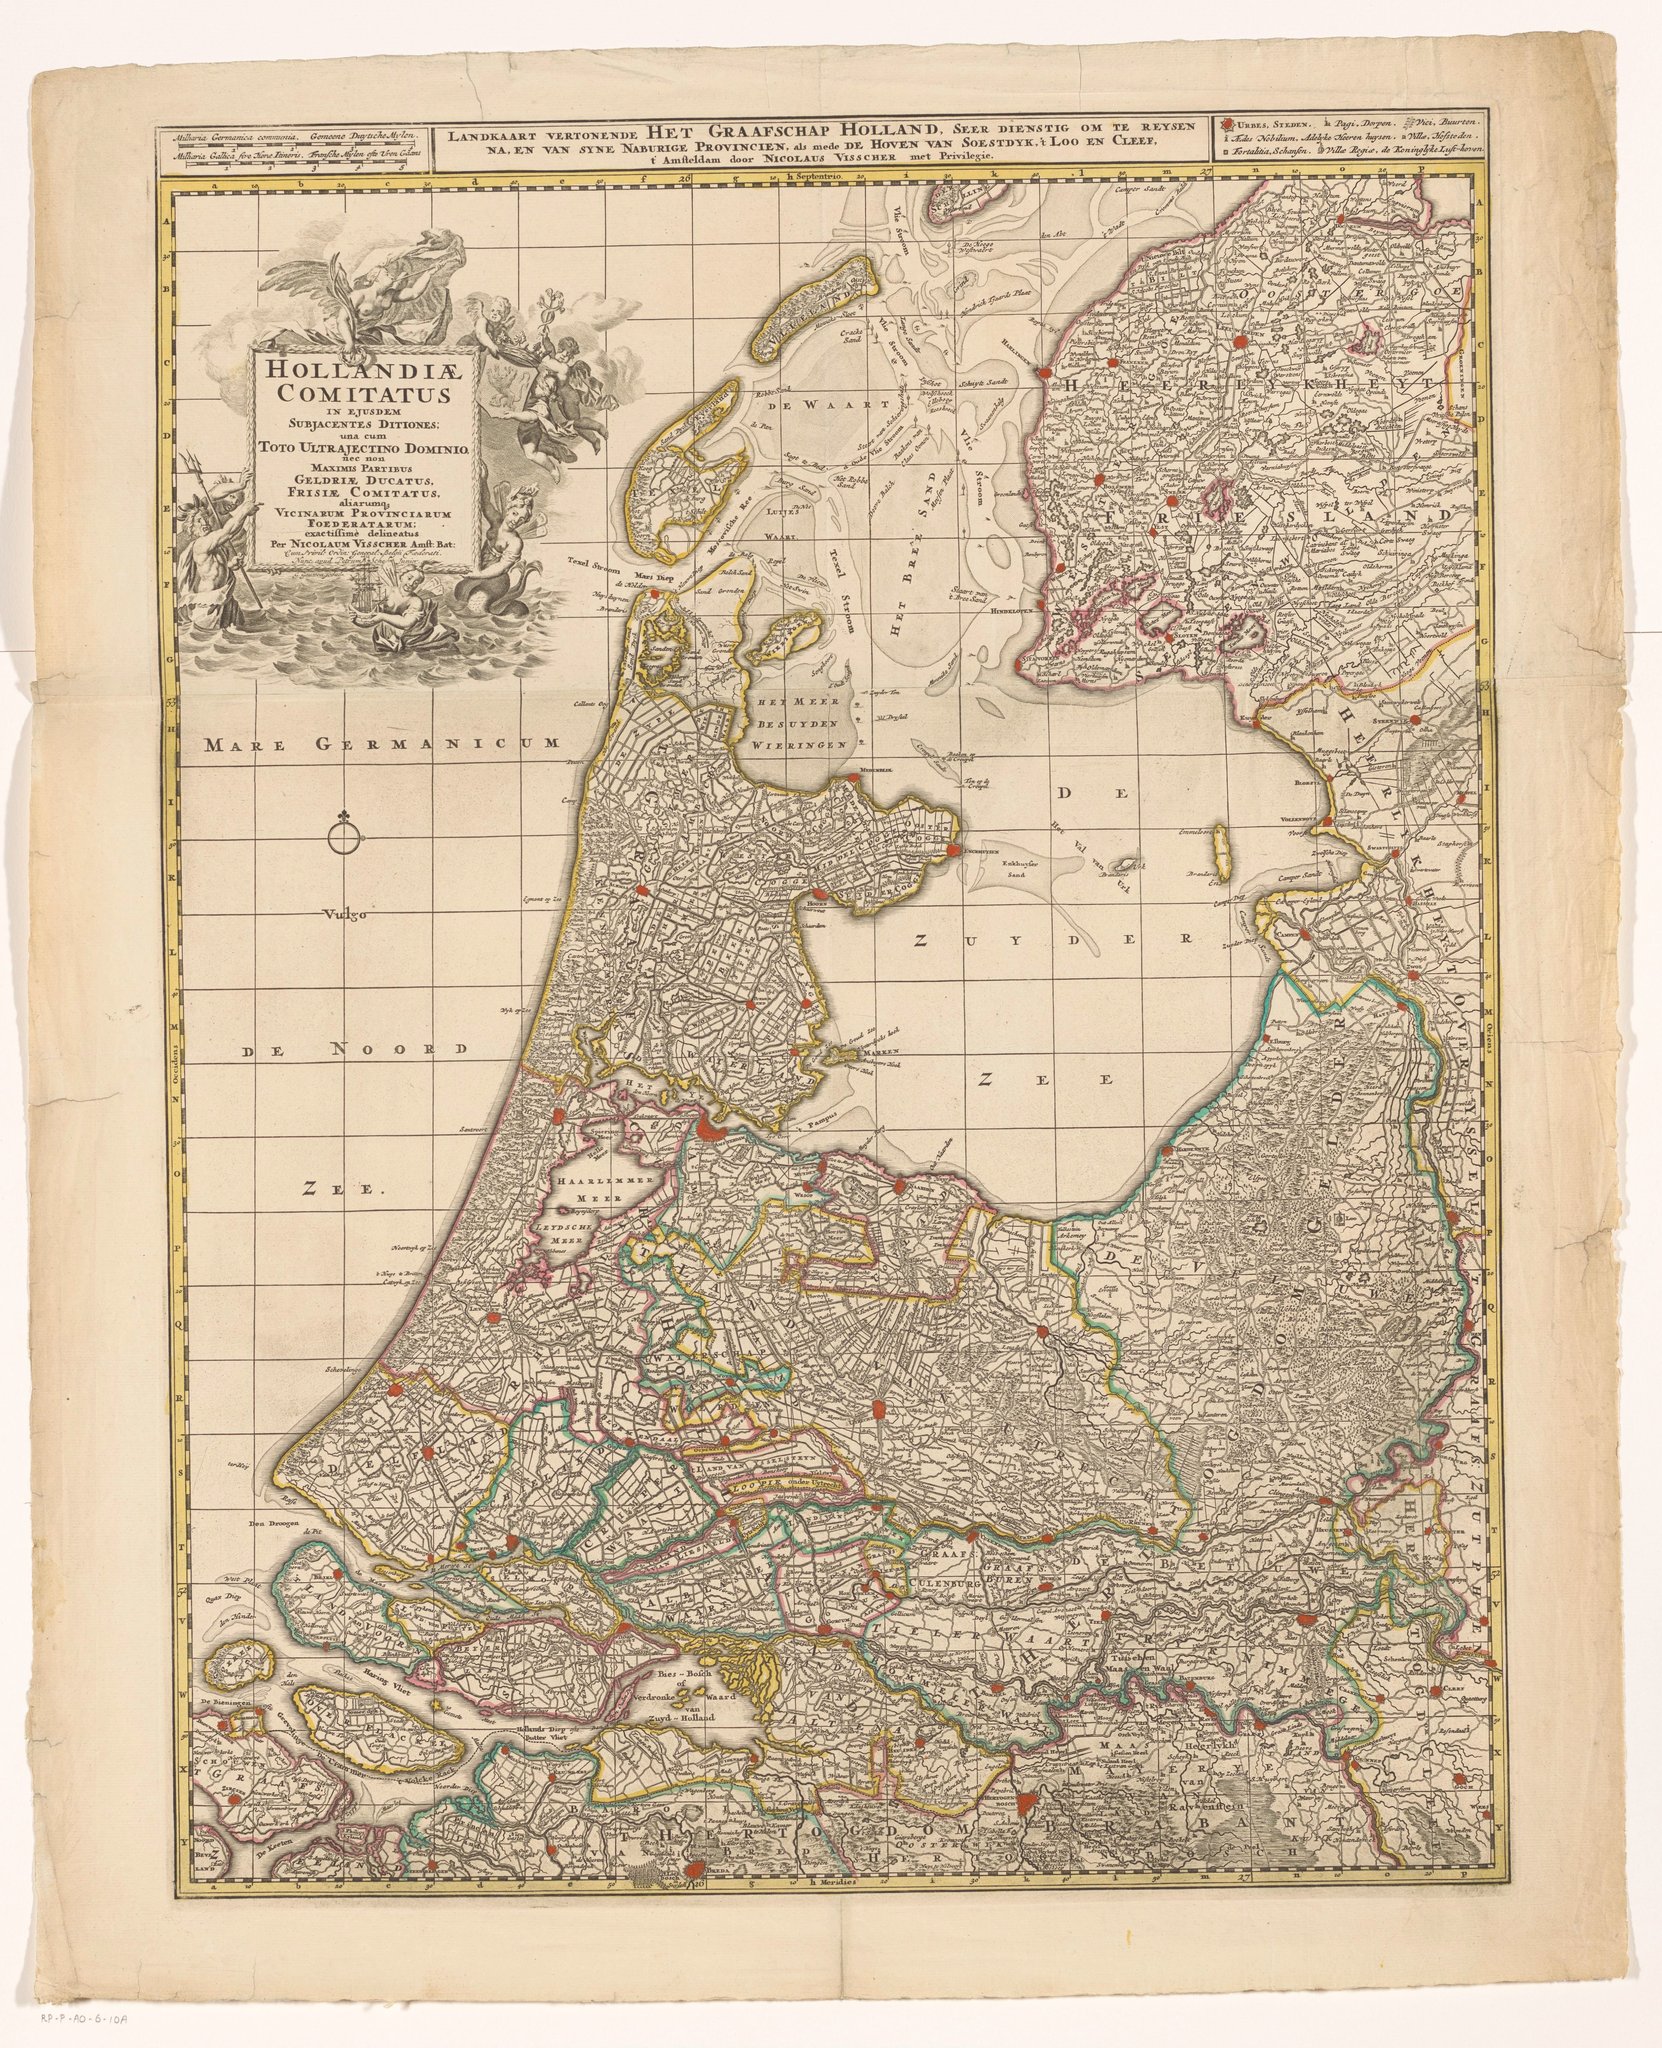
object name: print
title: Landkaart vertonende het graafschap Holland, seer dienstig om te reysen na, en van syne naburige provincien … / Hollandiae Comitatus in ejusdem subjacentes ditiones …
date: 1720-1775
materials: paper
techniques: engraving, hand coloring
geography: amsterdam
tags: (story of) neptune (poseidon), coat of arms (as symbol of the state, etc.), maps of separate countries or regions, merman - aa - mermaid, siren, fame; 'fama', 'fama buona', 'fama chiara' (ripa), holland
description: Kaart van het graafschap Holland en omliggende gebieden. Helemaal boven in het midden de Nederlandse titel. Links daarvan twee schaalstokken: Milliaria Germanica communia / Gemeene Duytsche mylen; Milliaria Gallica sive horae itineris / Fransche mylen ofte uren gaens. Rechts van die titel de legenda. Linksboven op de kaart een cartouche met de Latijnse titel. Daaromheen Fama, putti met het wapen van het graafschap Holland, zeemeerminnen en Neptunus. De kaart is voorzien van een zoekrooster en een gradenverdeling langs de randen.